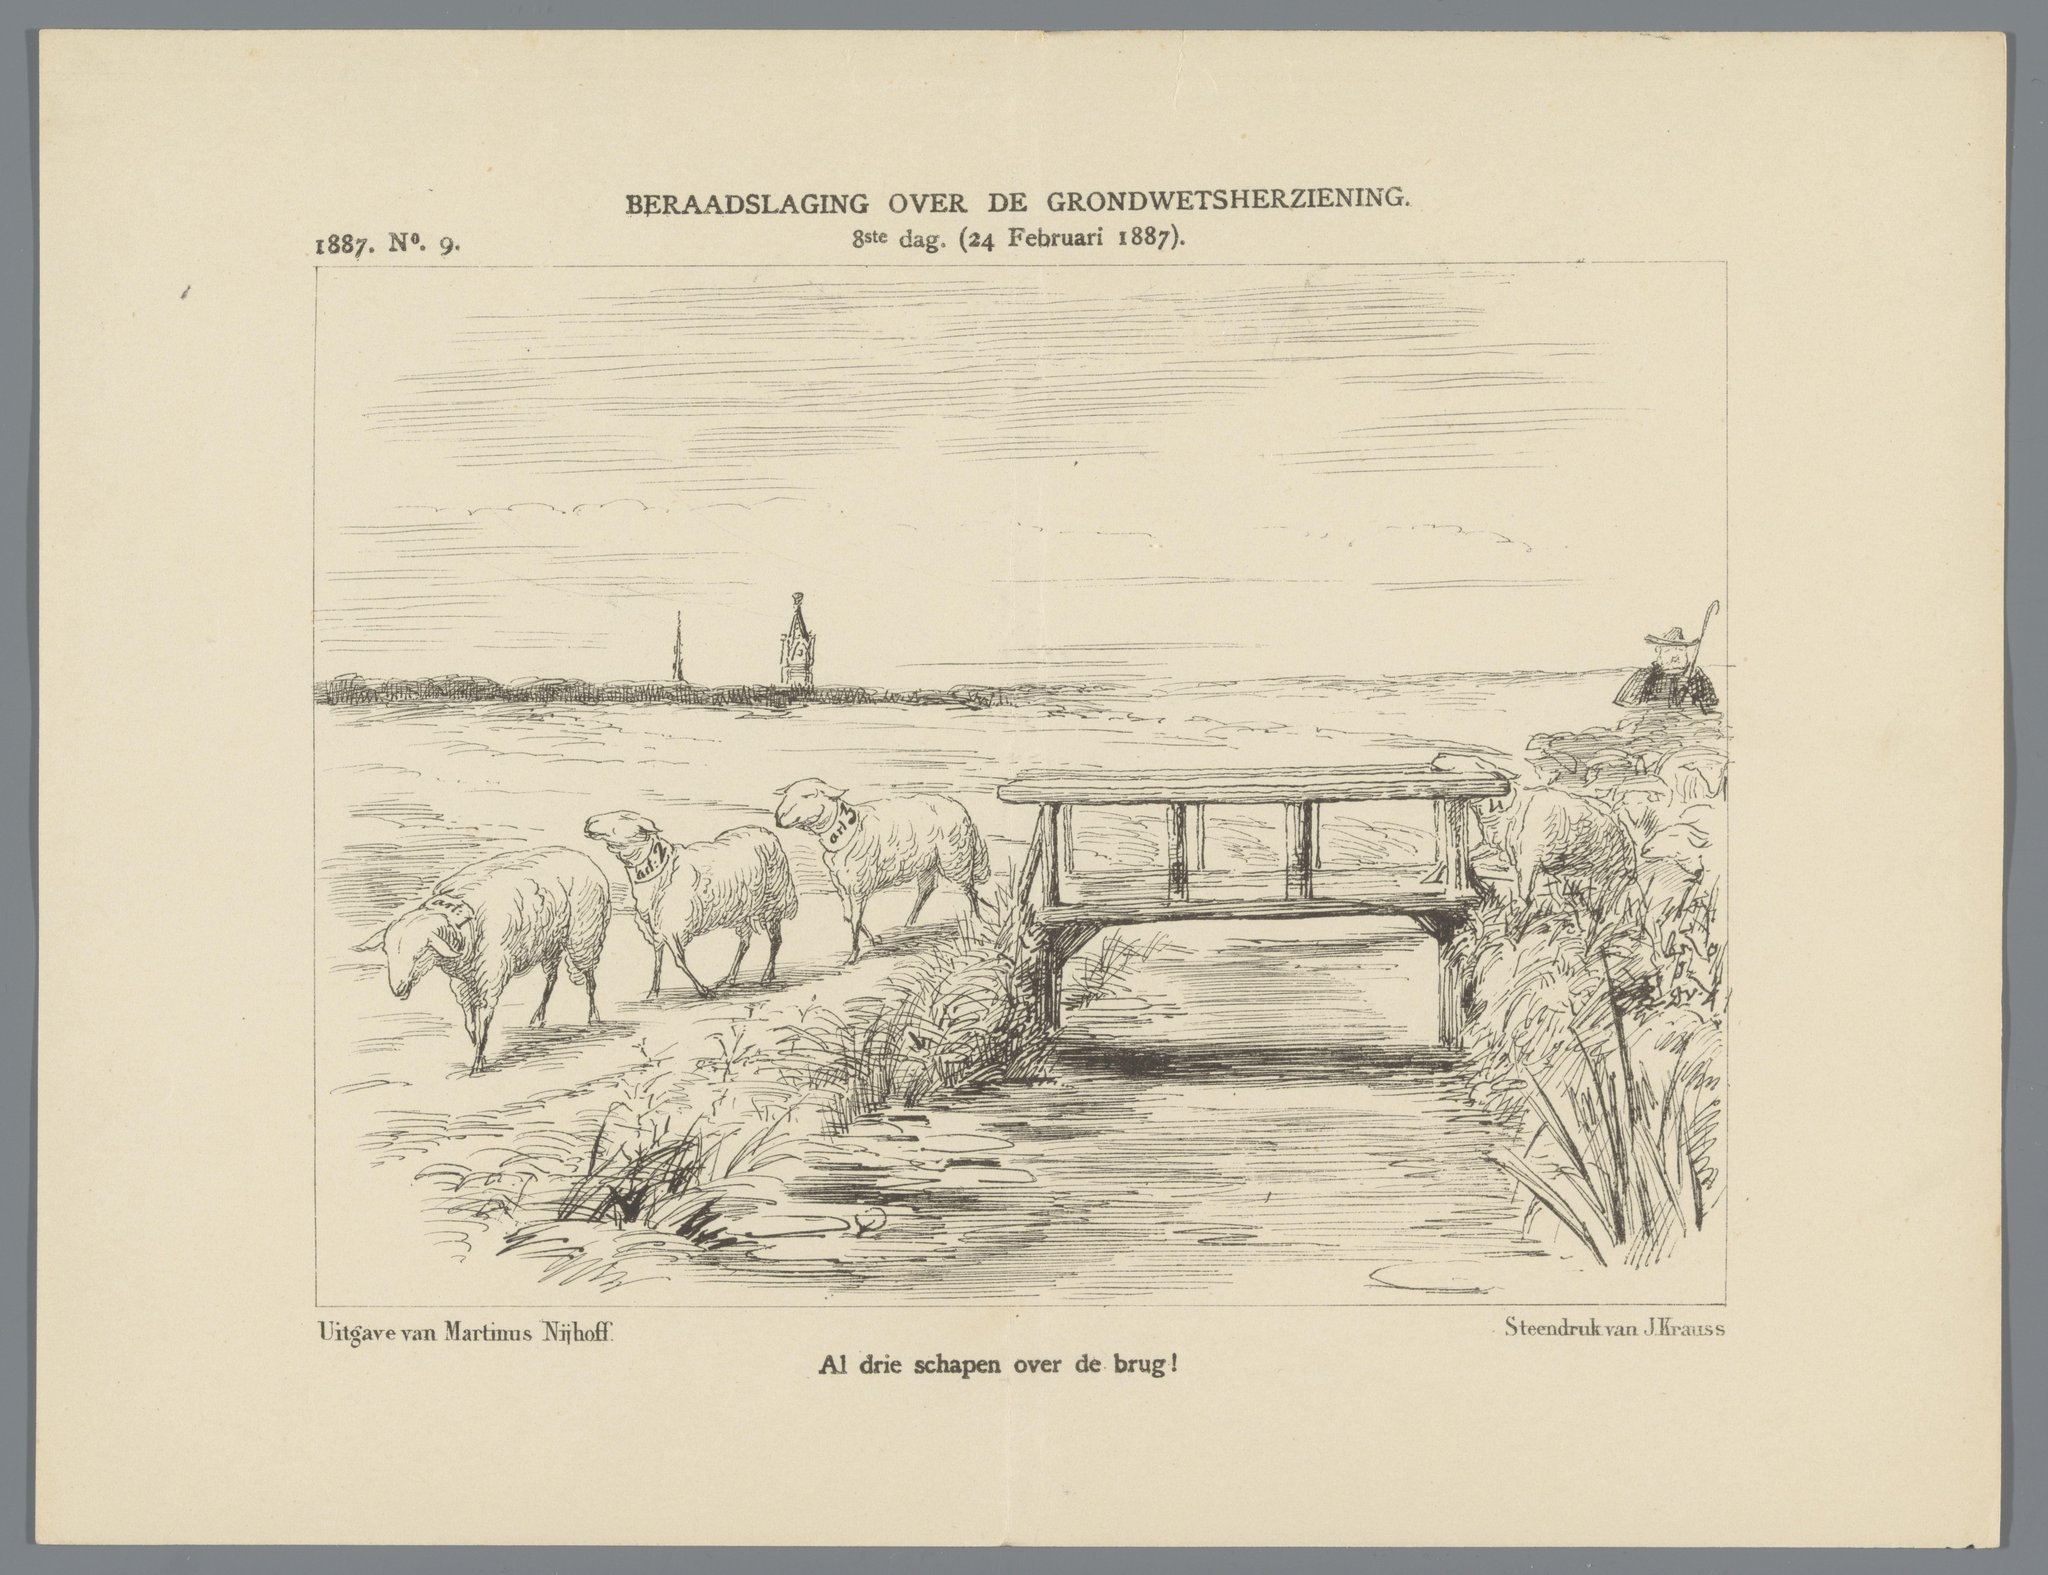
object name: cartoon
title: Spotprent op de grondwetsherzieing, 1887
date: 1887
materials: paper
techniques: lithograph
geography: the hague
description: Spotprent op de grondwetsherzieing, februari 1887. Plaat verschenen bij het weekblad De Nederlandsche Spectator, nr. 9, 1887.